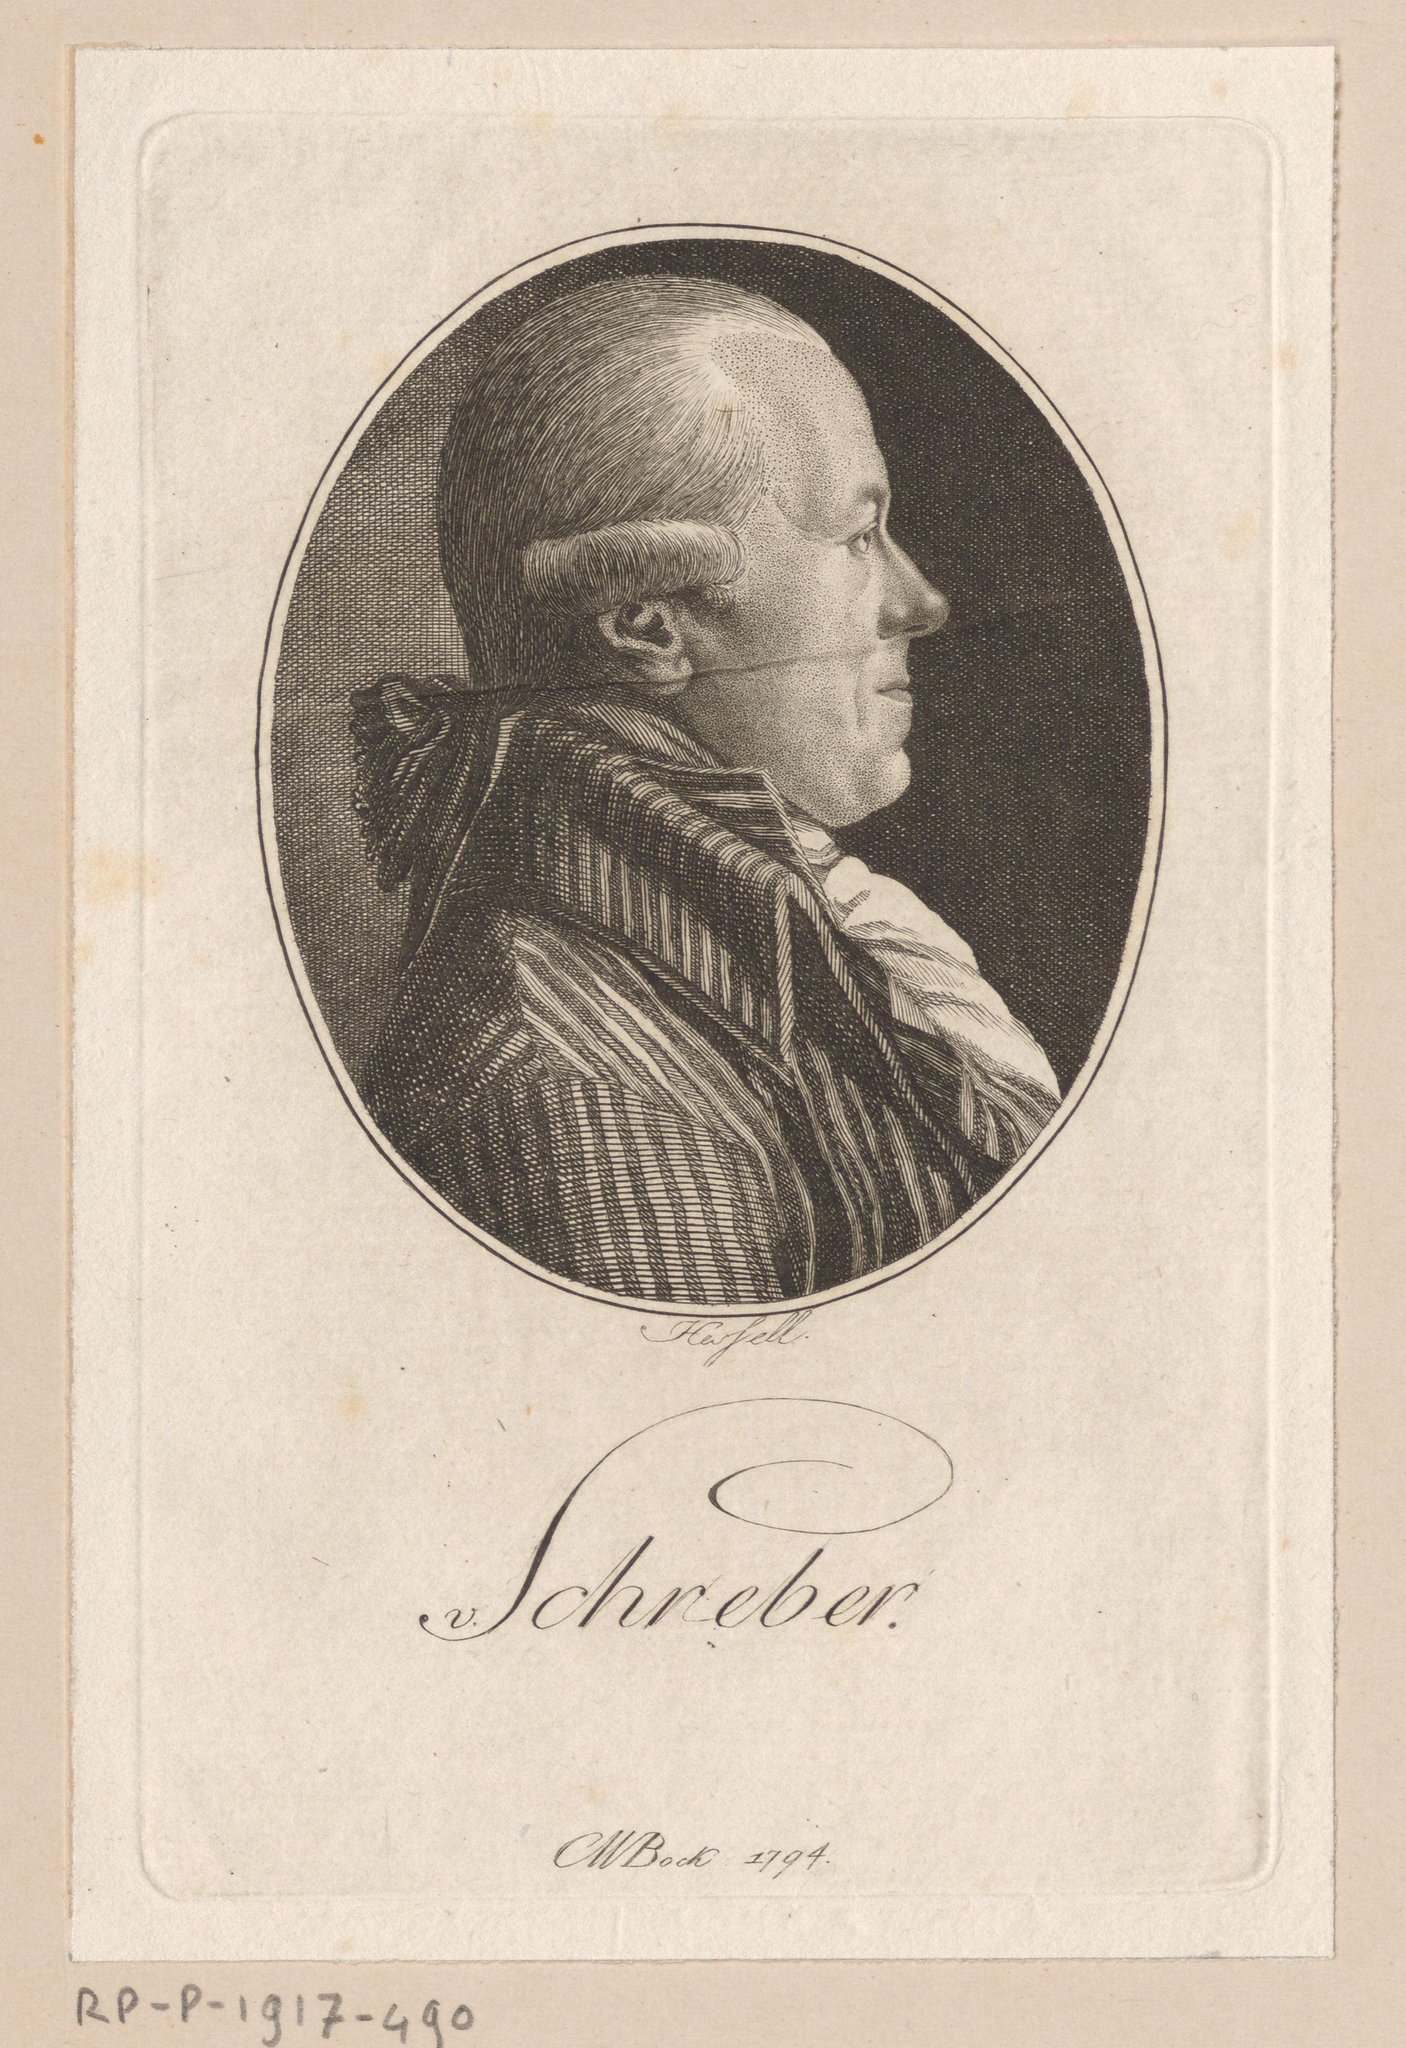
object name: print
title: Portret van Johann Christian Daniel von Schreber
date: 1794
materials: paper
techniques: etching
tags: historical persons, physician, doctor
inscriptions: collector's mark: Lugt 2228